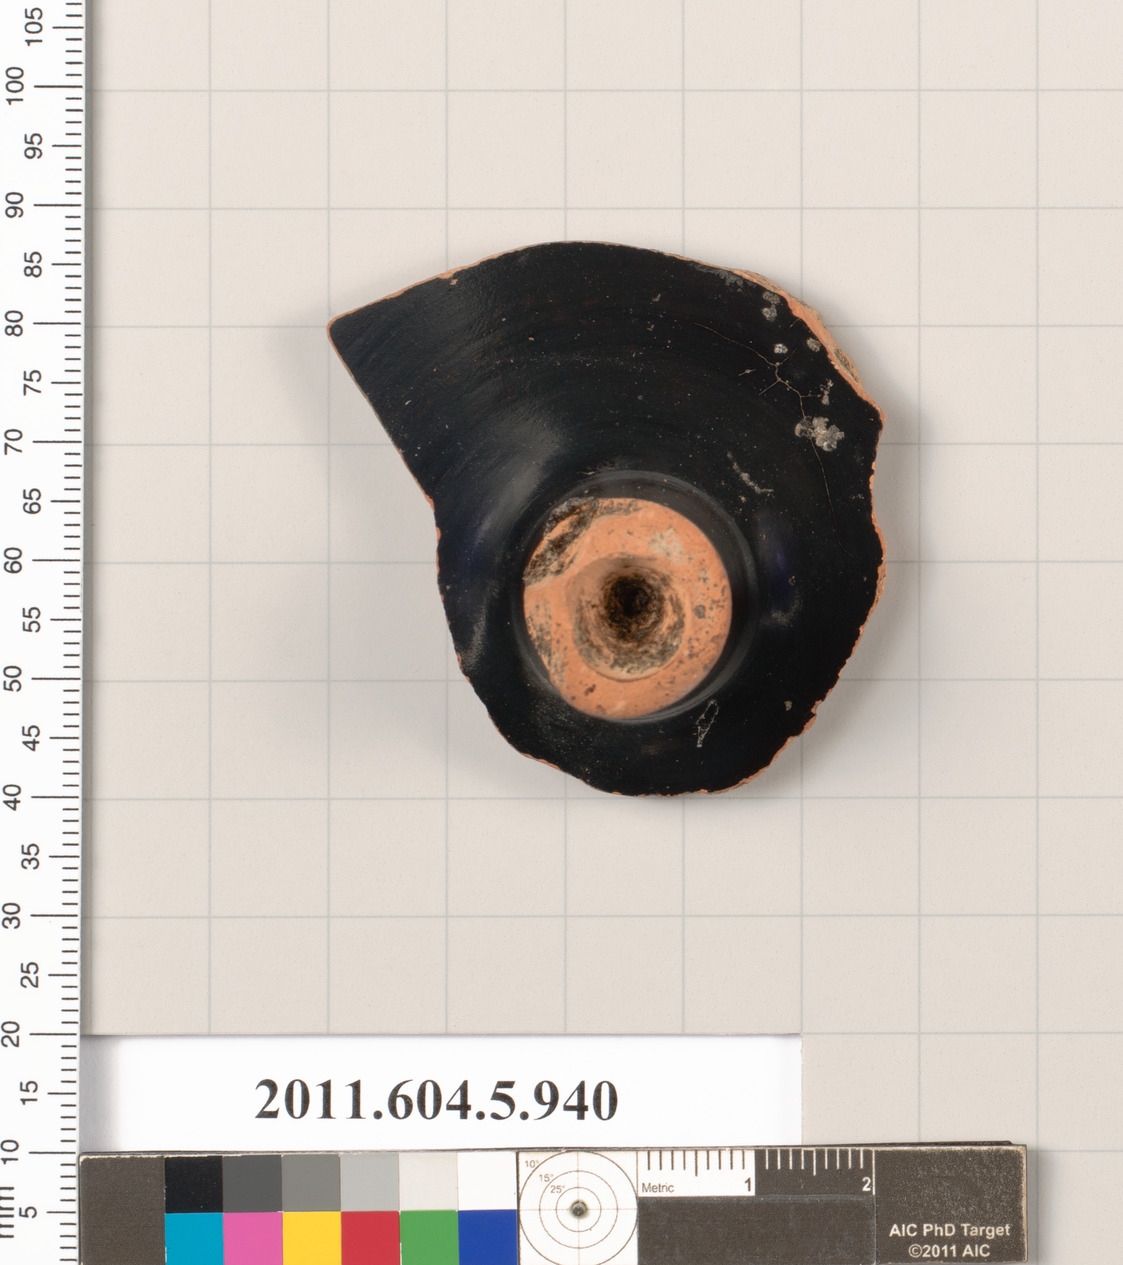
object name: kylix fragment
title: Terracotta fragment of a kylix (drinking cup)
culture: greek, attic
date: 600-401 BCE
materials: terracotta